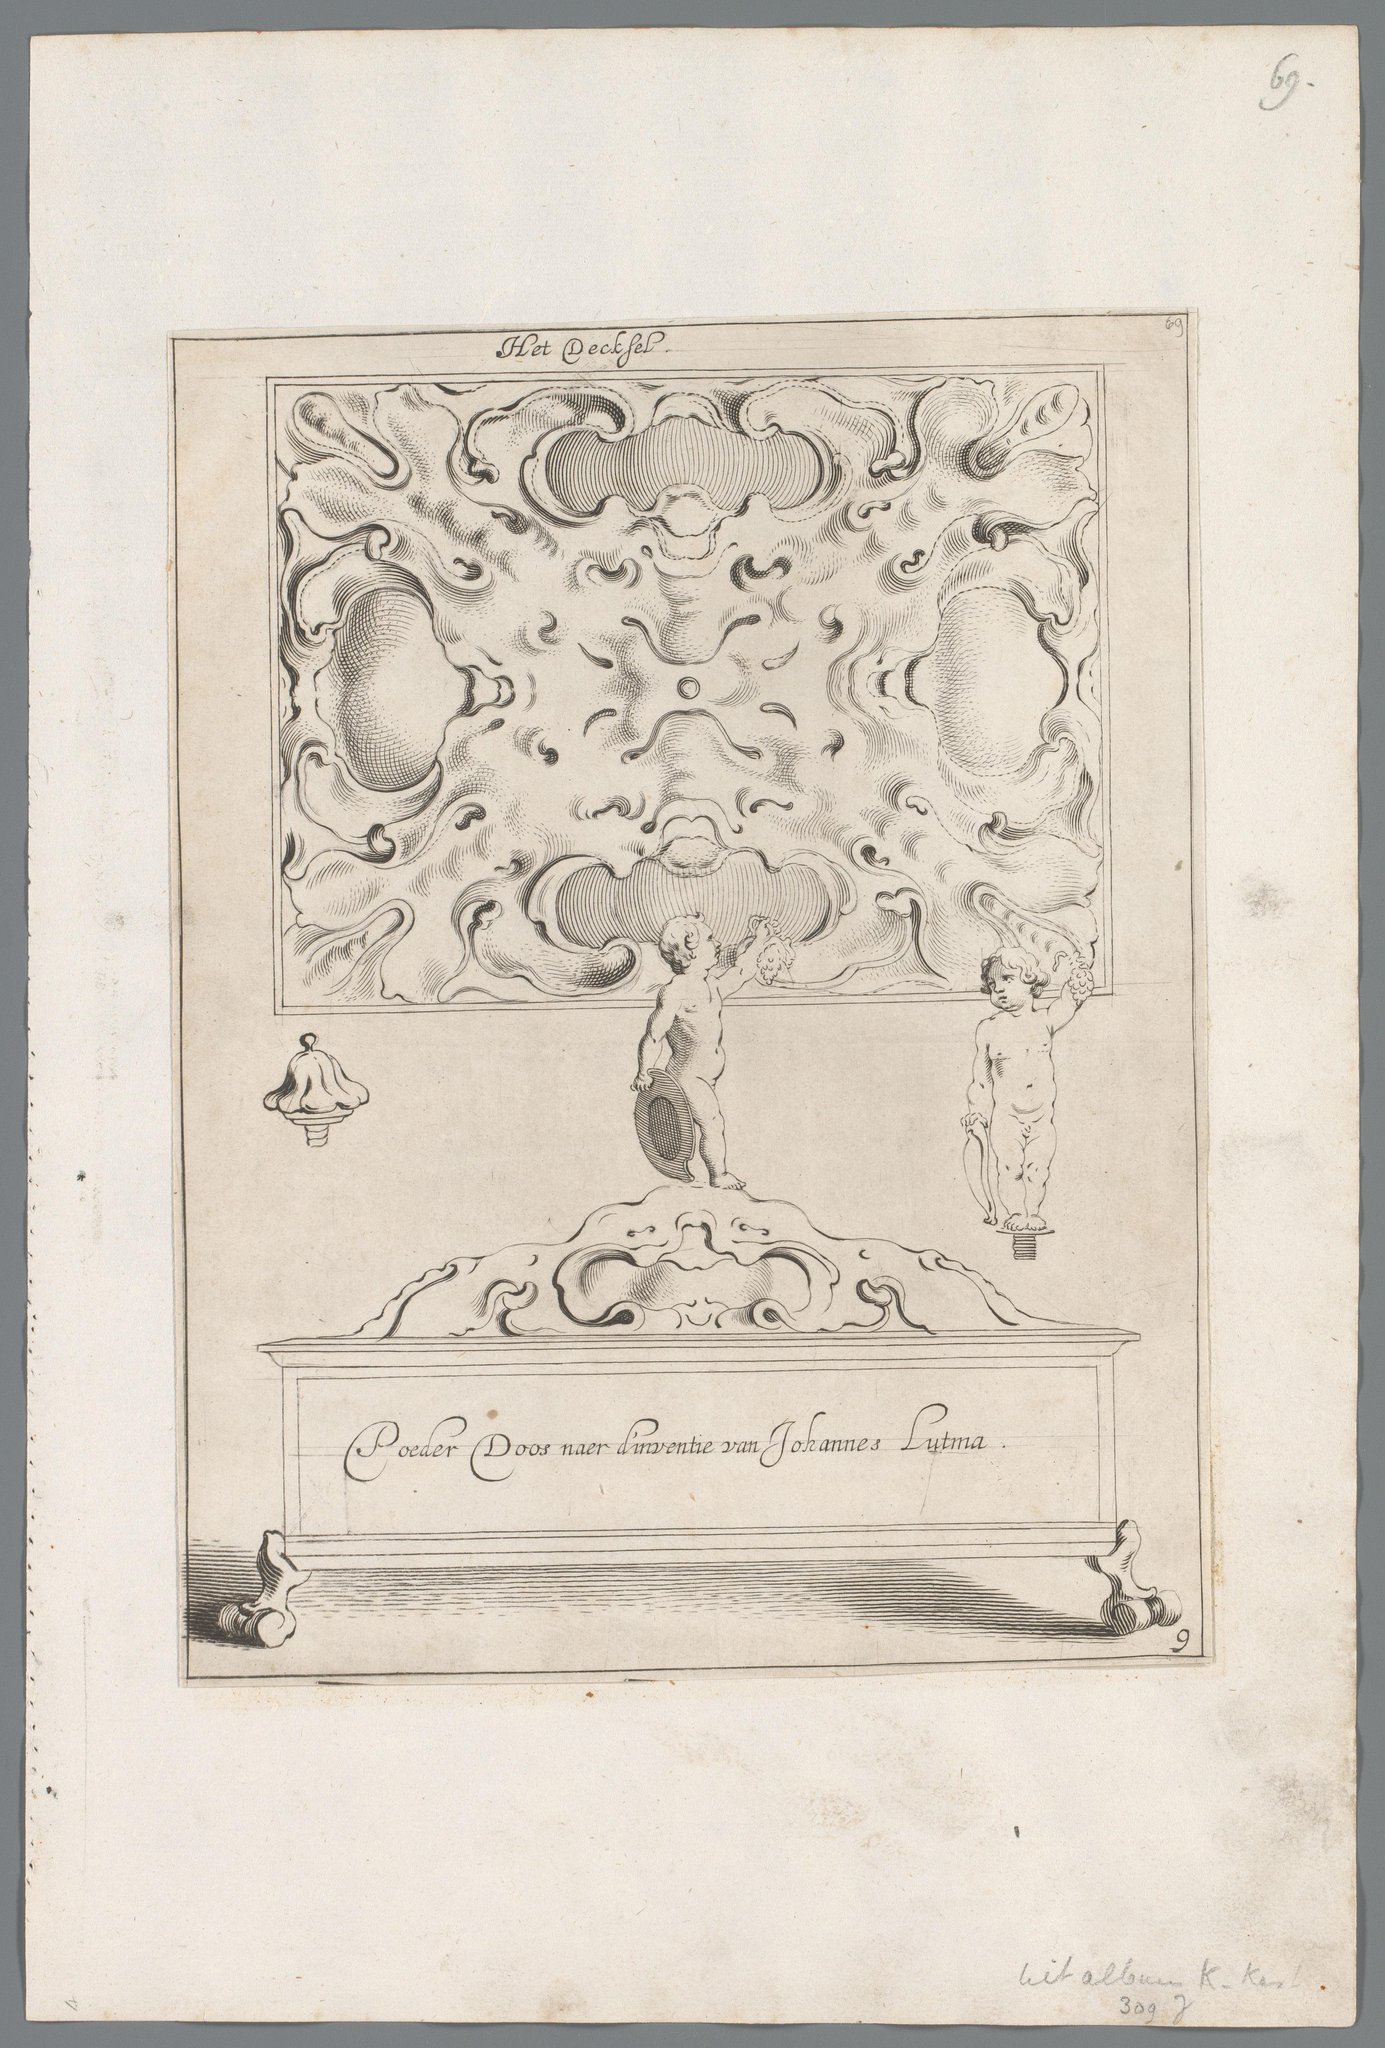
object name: ornament print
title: Ontwerpen om in goud, zilver, hout en steen uit te werken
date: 1651-1653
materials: paper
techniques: engraving, etching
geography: amsterdam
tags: snuff-box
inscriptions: collector's mark: Lugt 2760, collector's mark: Lugt 2228